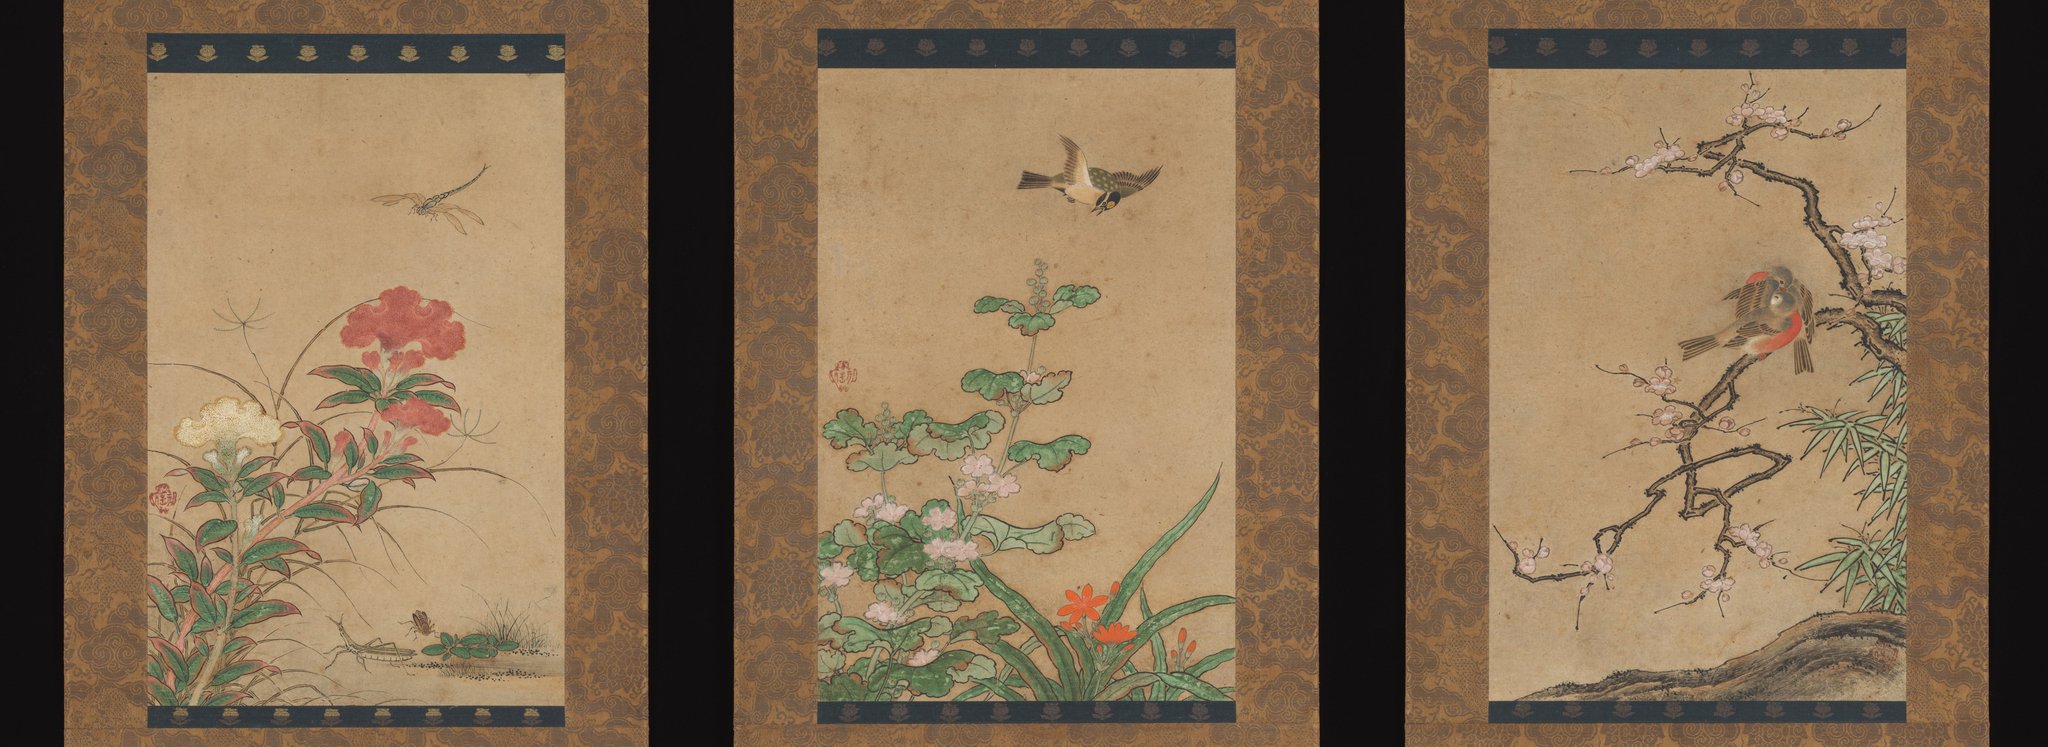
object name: hanging scroll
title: Birds and Flowers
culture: japanese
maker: kano motonobu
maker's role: artist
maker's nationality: japanese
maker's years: 1477-1559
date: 1534-1566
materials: ink, paper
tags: birds